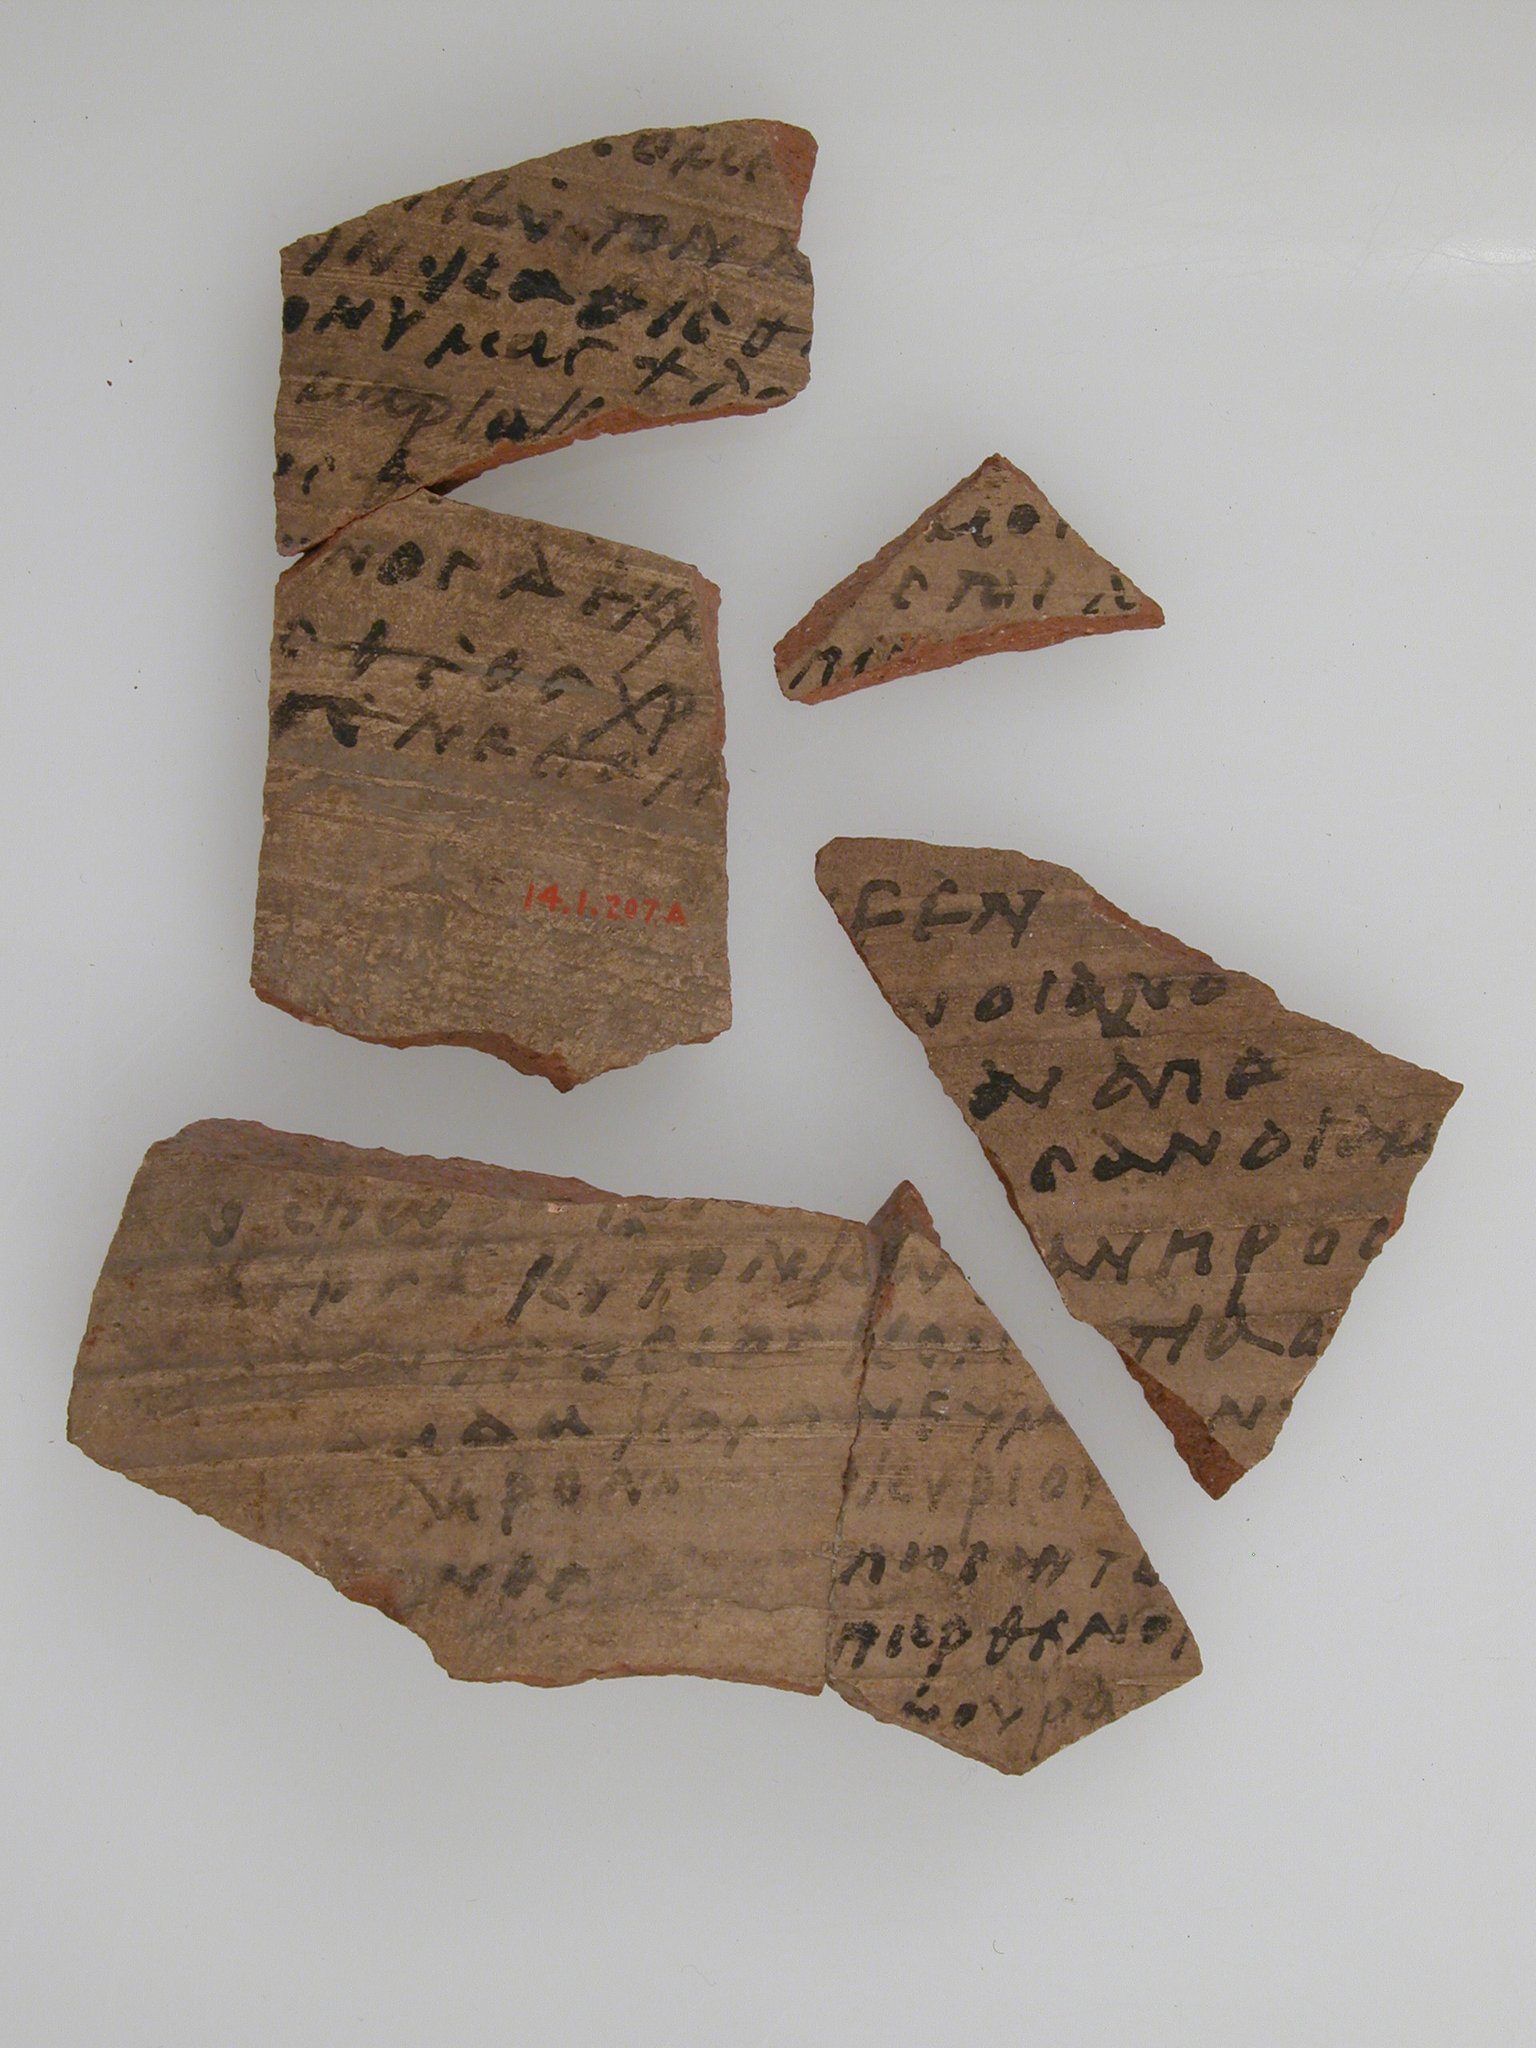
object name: ostrakon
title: Ostrakon with Biblical Text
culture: coptic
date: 580-640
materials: ink, pottery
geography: egypt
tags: greek